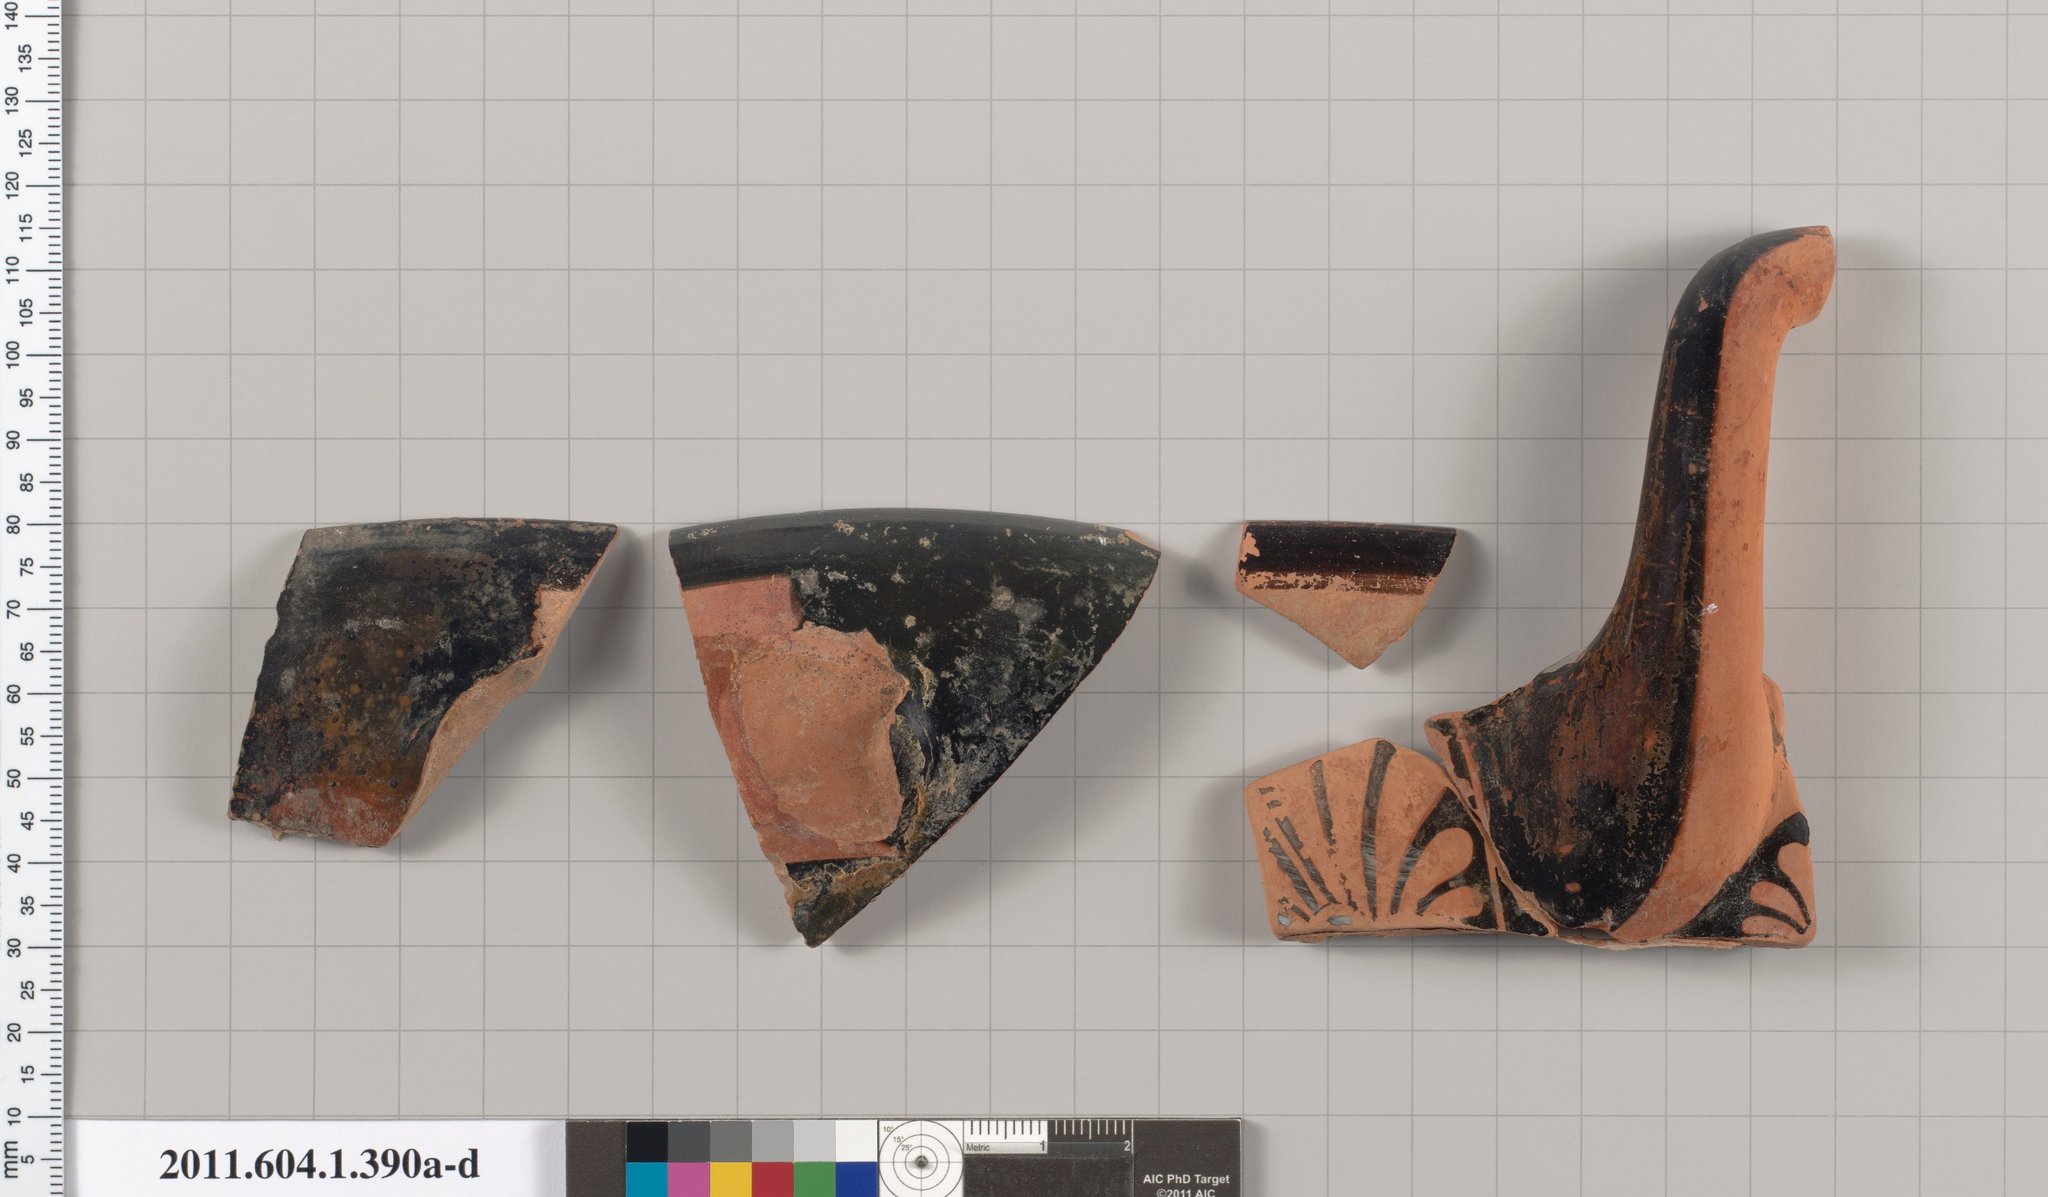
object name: kylix fragment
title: Terracotta fragments of kylikes (drinking cups)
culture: greek, attic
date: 460-450 BCE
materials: terracotta